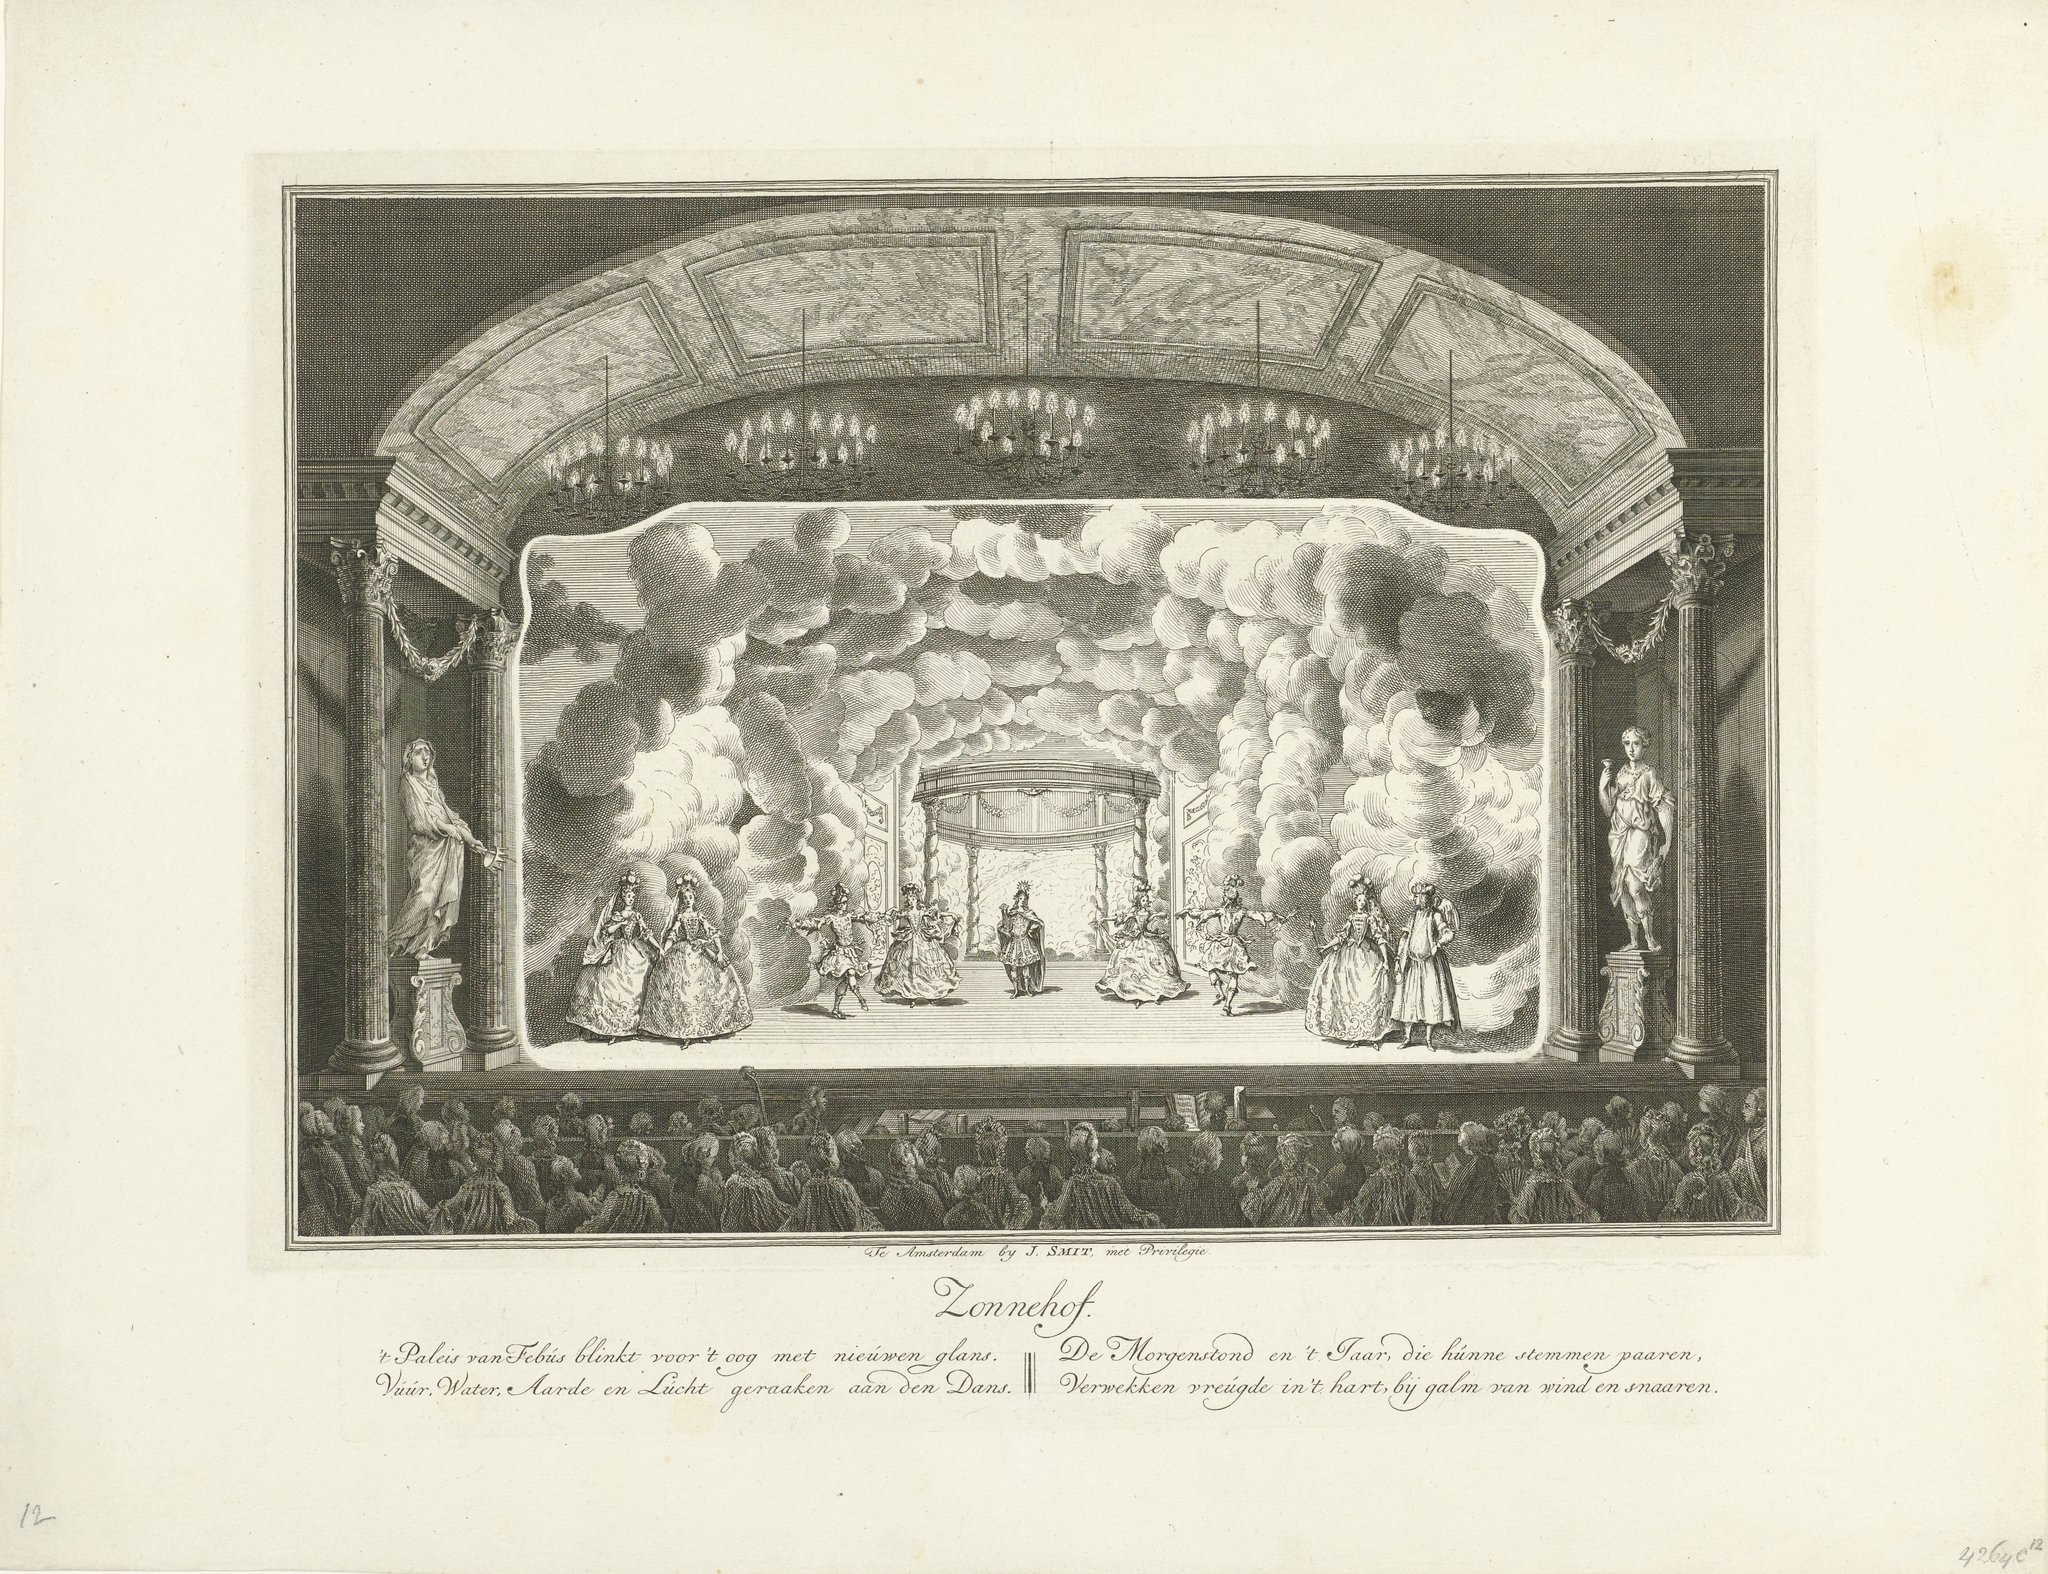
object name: print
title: Schouwburg met toneeldecor: Zonnehof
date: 1738-1740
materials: paper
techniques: engraving, etching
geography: amsterdam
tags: theatre, theatrical performance, stage design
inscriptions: collector's mark: Lugt 2228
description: Toneelvoorstelling in de Amsterdamse Schouwburg op de Keizersgracht met het coulissendecor Zonnehof met scène uit: Het eeuwgetijde van den Amsteldamschen Schouwburg. Het decor gedrukt van een aparte plaat binnen een nieuw passe-partout met de zaal, orkestbak en de façade van het toneel met zuilen en kroonluchters. De titel en een vierregelig vers ook gedrukt van een aparte plaat. Onderdeel van een latere uitgave van de serie van 12 toneeldecors.